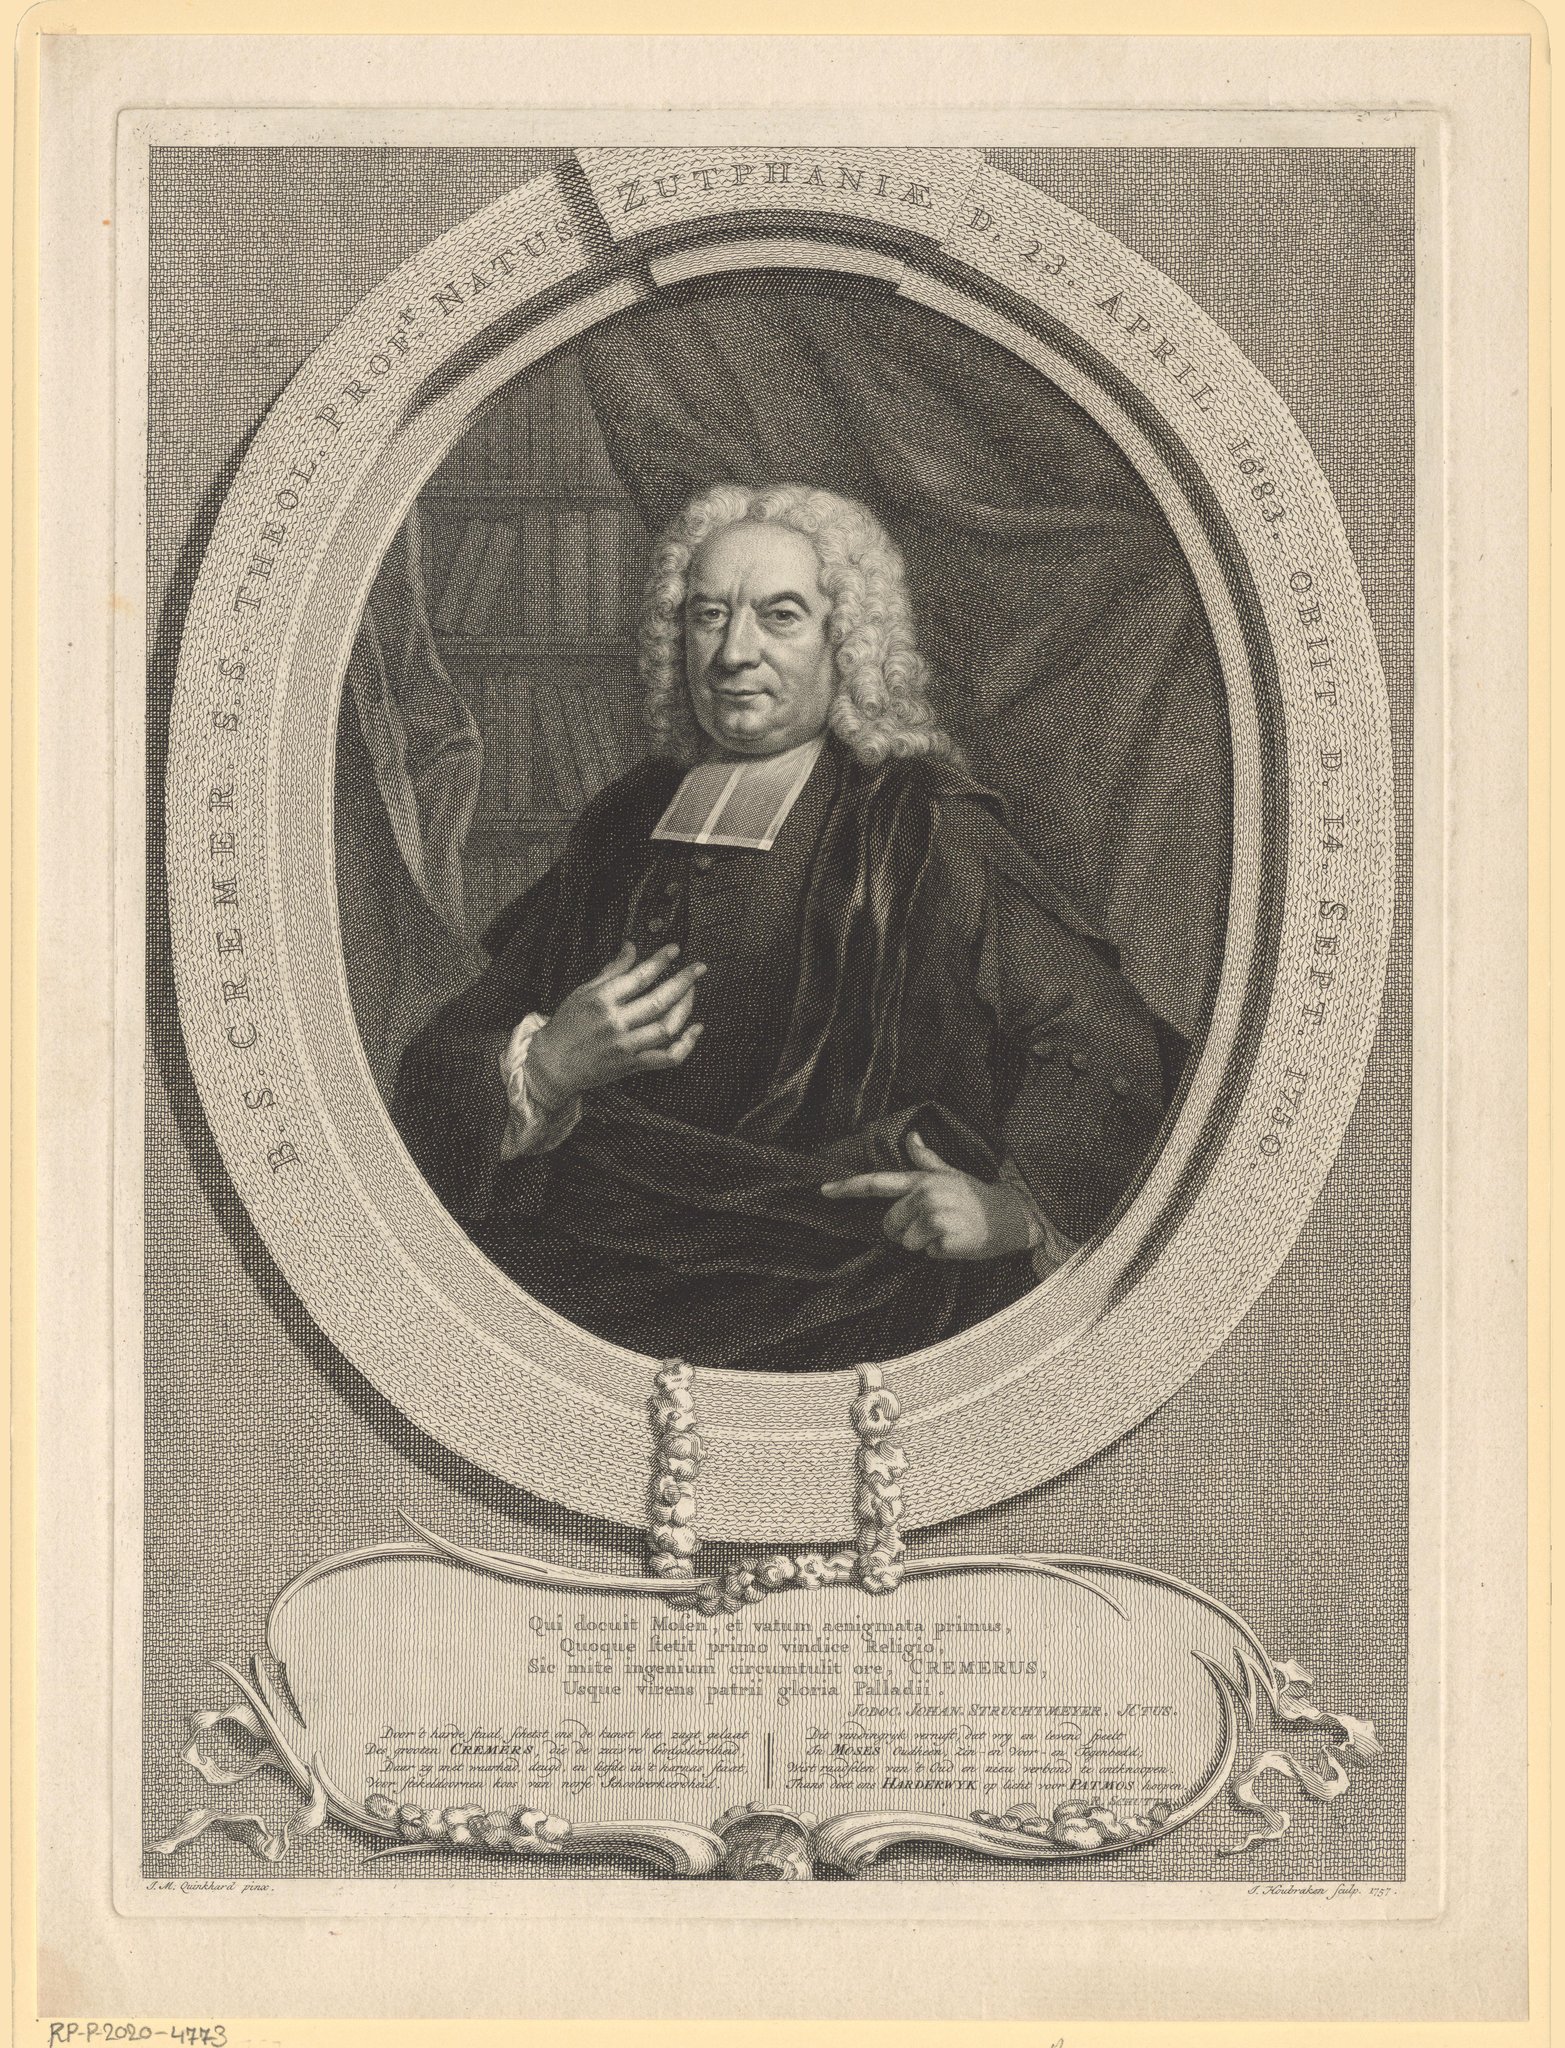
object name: print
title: Portret van Bernard Sebastiaan Cremer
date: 1757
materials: paper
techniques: engraving, etching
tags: historical persons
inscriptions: date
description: Onder het portret een vierregelig en een achtregelig vers.